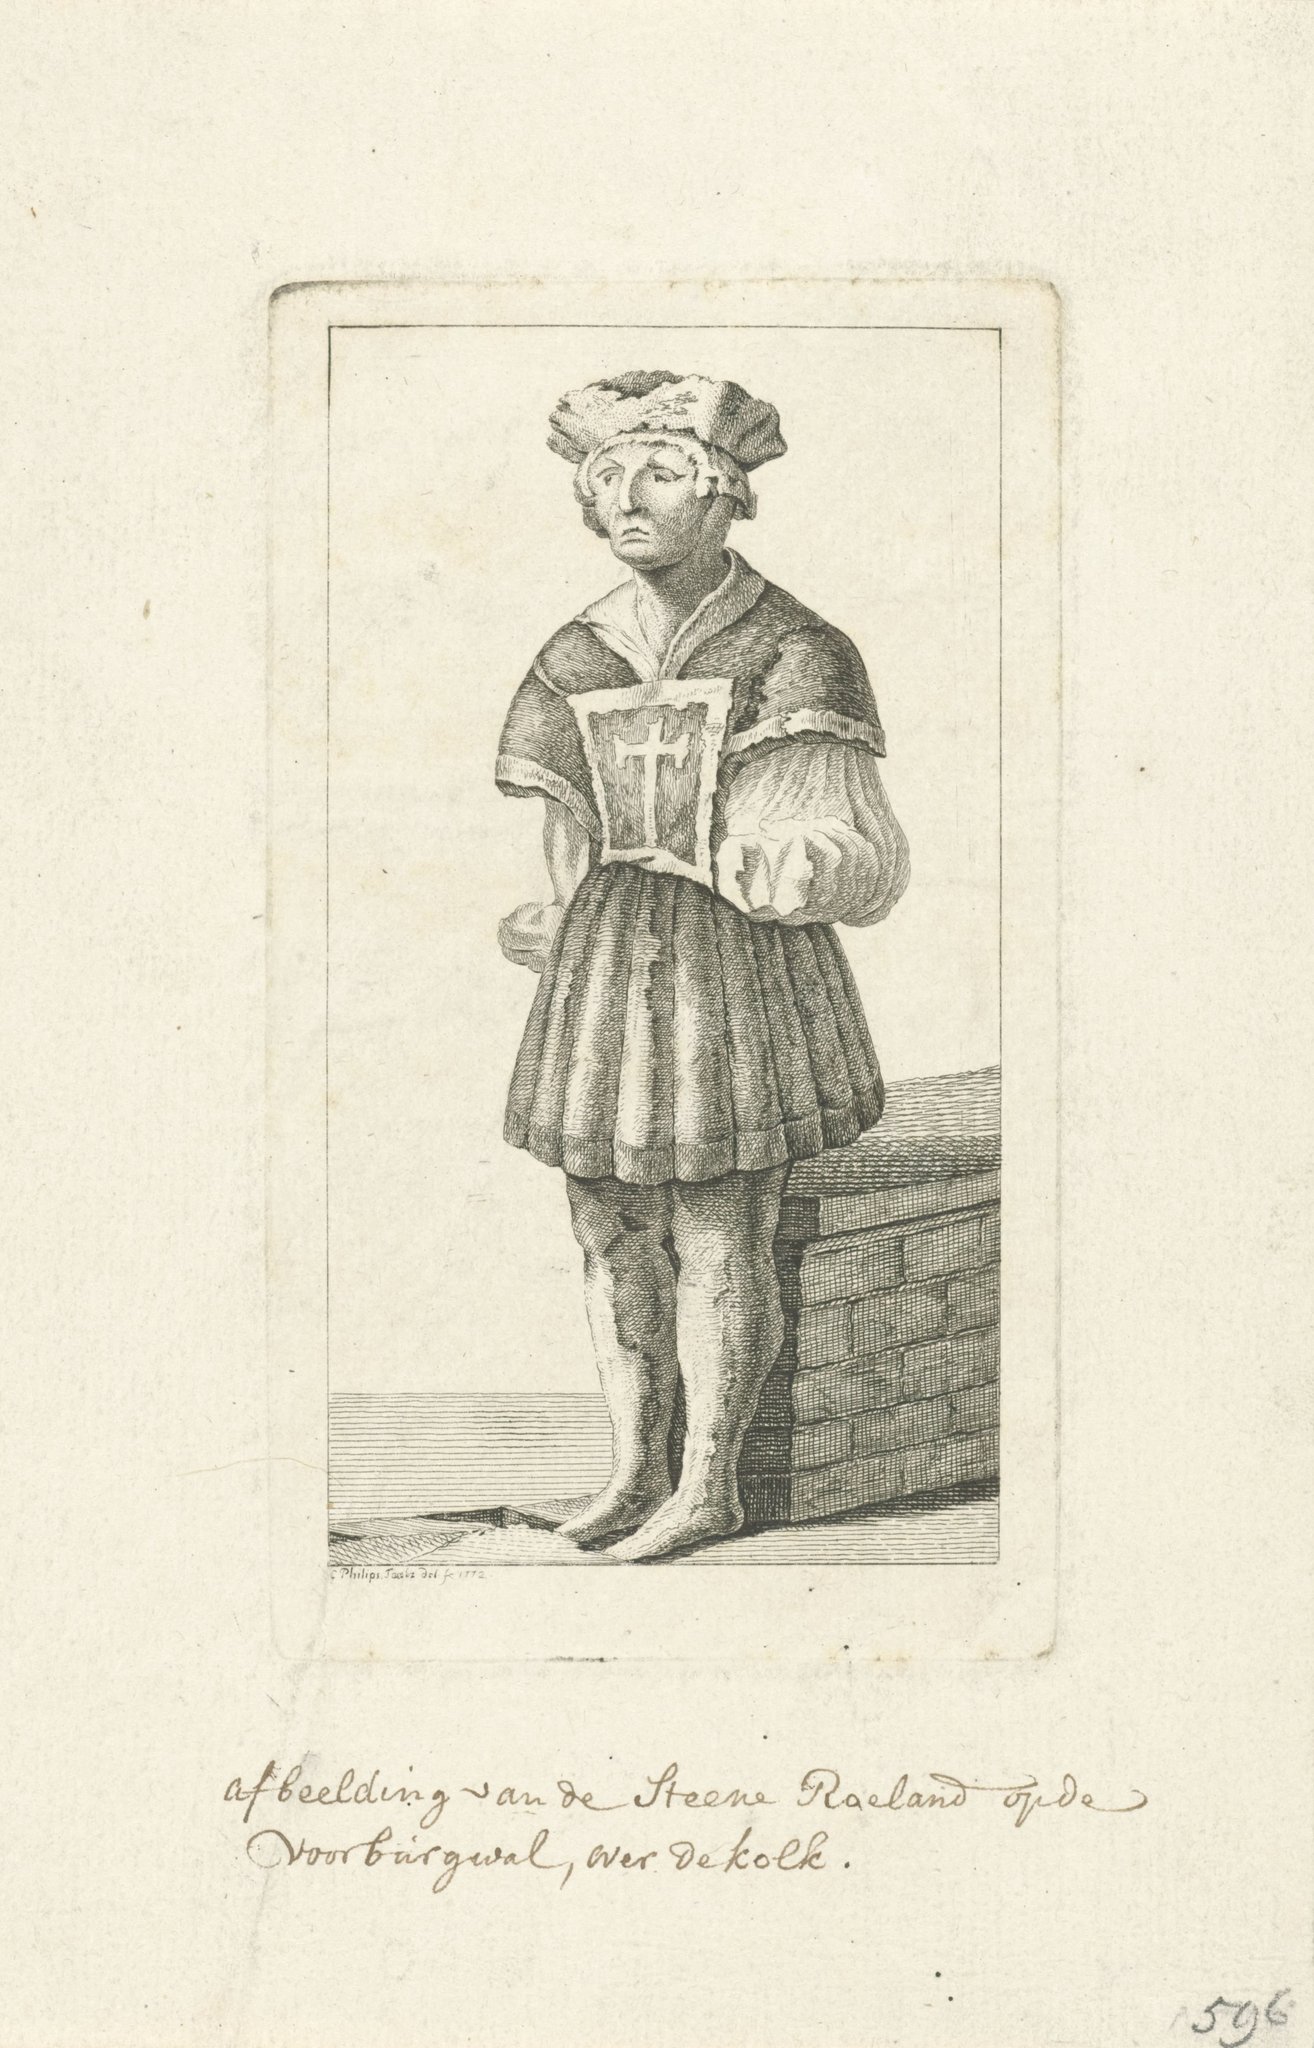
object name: print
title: Standbeeld de Stenen Roelandt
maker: caspar jacobsz. philips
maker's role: draughtsman, print maker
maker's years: 1732-1789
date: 1772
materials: paper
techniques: etching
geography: amsterdam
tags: piece of sculpture, reproduction of a piece of sculpture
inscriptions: collector's mark: Lugt 2228, inscription: ‘Afbeelding [...] de Kolk.’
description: Standbeeld de Stenen Roelandt, dat zich bevindt op de Nieuwezijds Voorburgwal, tussen de Korte Kolksteeg en de Korte Lijnbaanssteeg, te Amsterdam.